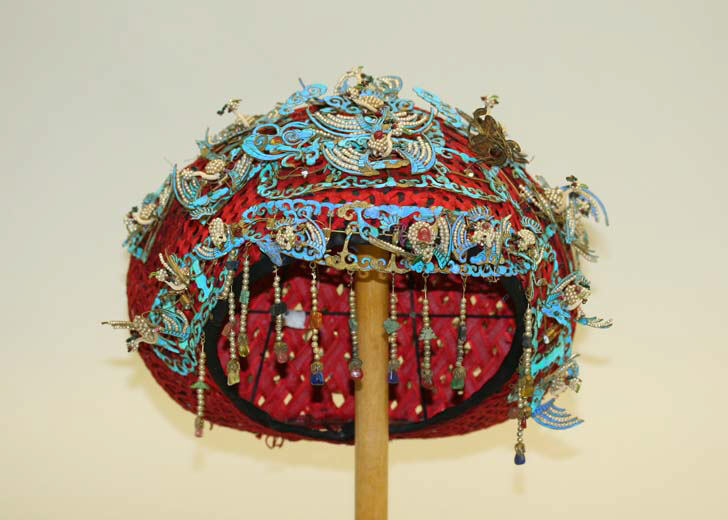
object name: hat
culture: chinese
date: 1801-1900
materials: feather, glass, metal, paint, paper, silk, stone